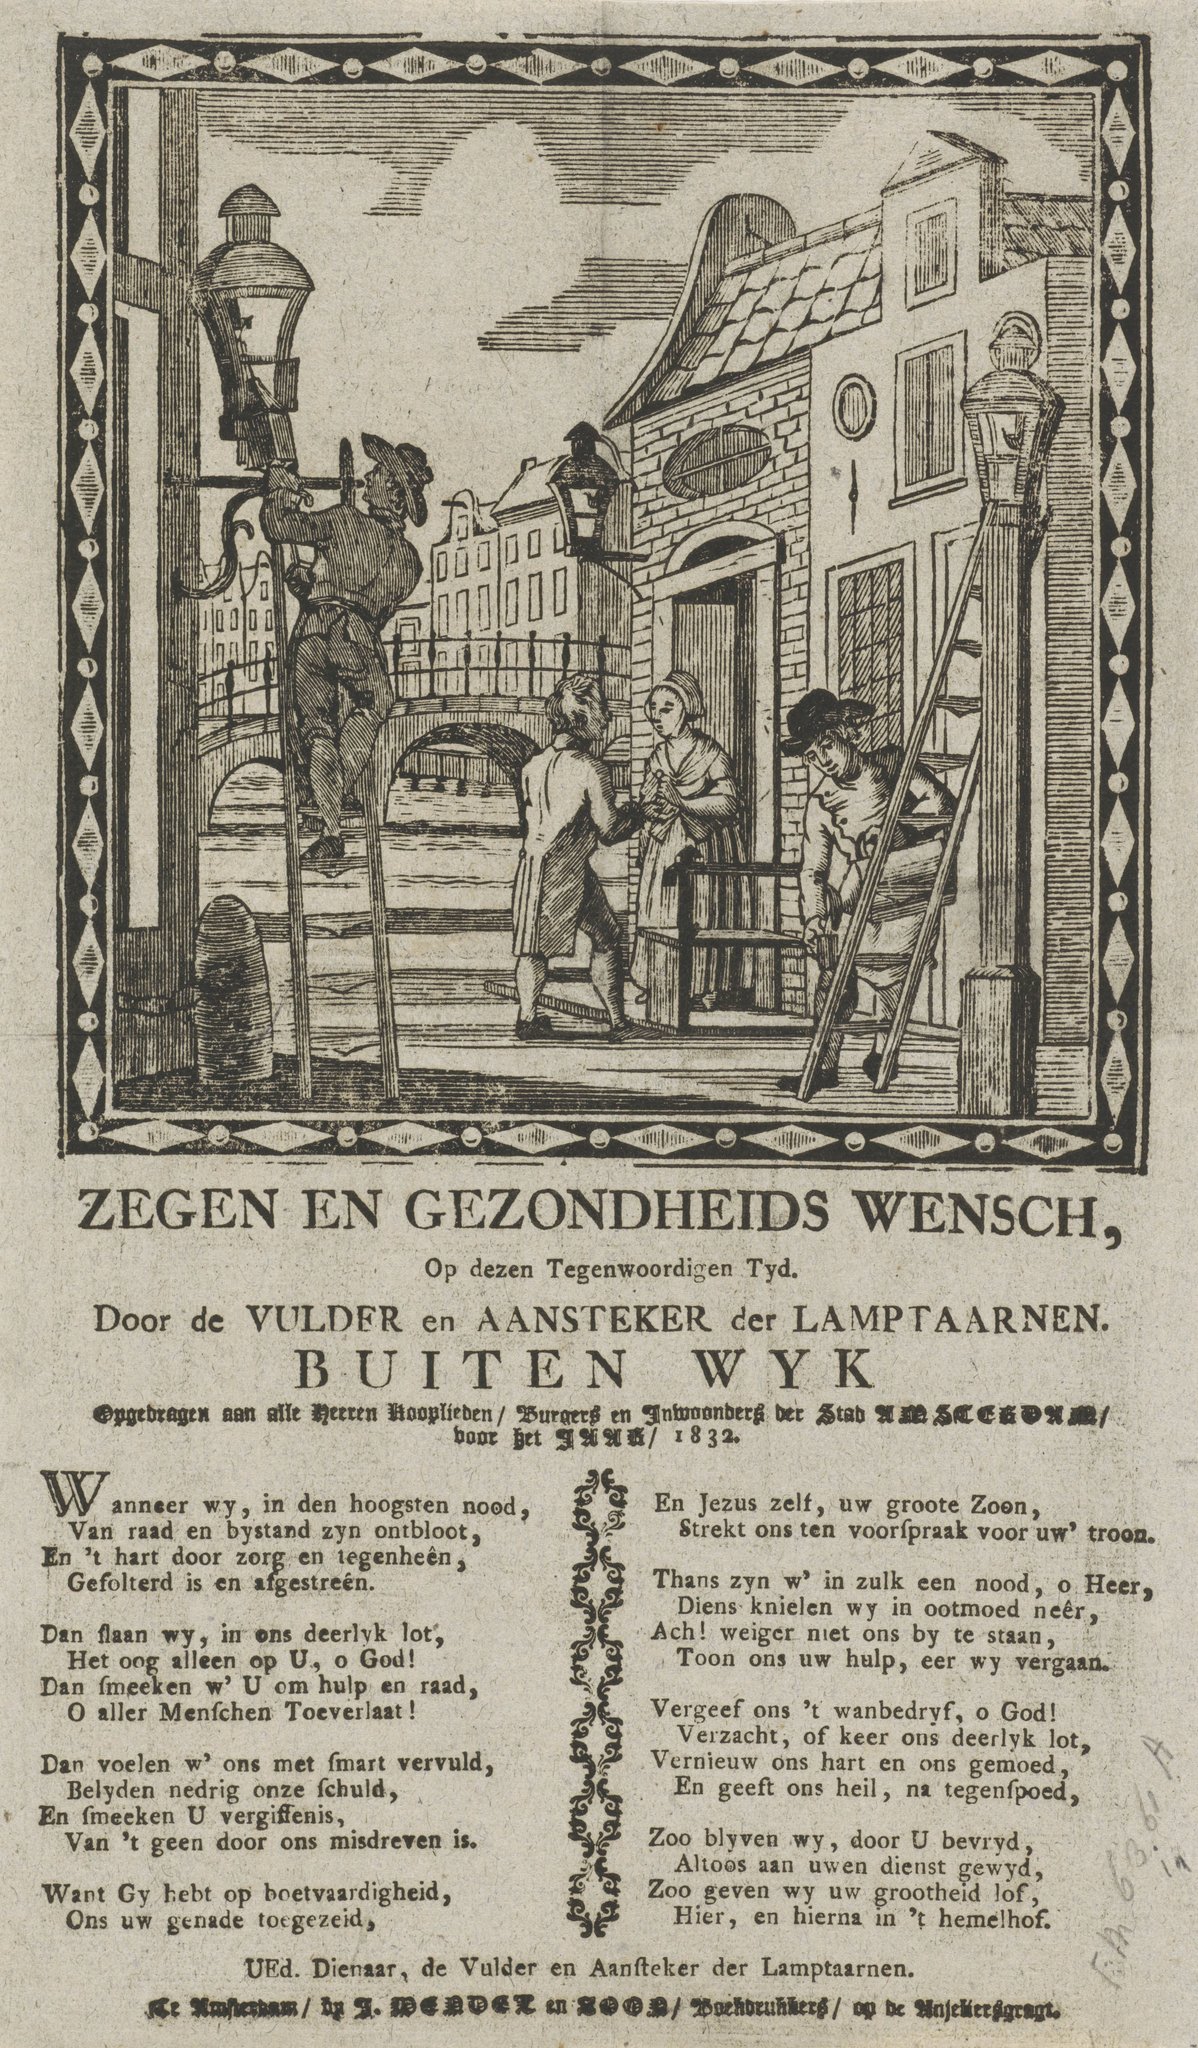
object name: print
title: Nieuwjaarswens van de lantaarnopstekers van Amsterdam voor het jaar 1832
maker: Anonymous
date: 1831-1832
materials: paper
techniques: letterpress printing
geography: amsterdam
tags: oil-lamp (+ kindling a light; lit, burning light, lamp, candle), street lighting, street, amsterdam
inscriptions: collector's mark: Lugt 2228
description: Nieuwjaarswens van de Amsterdamse lantaarnopstekers en vullers voor het jaar 1832. Gezicht in een straat in Amsterdam waar twee mannen bezig zijn de straatlantaarns te vullen en aan te steken. Een derde man haalt geld op bij een huis. Met gedicht in twee kolommen. Van de lantaarnopstekers in de Buitenwijk.